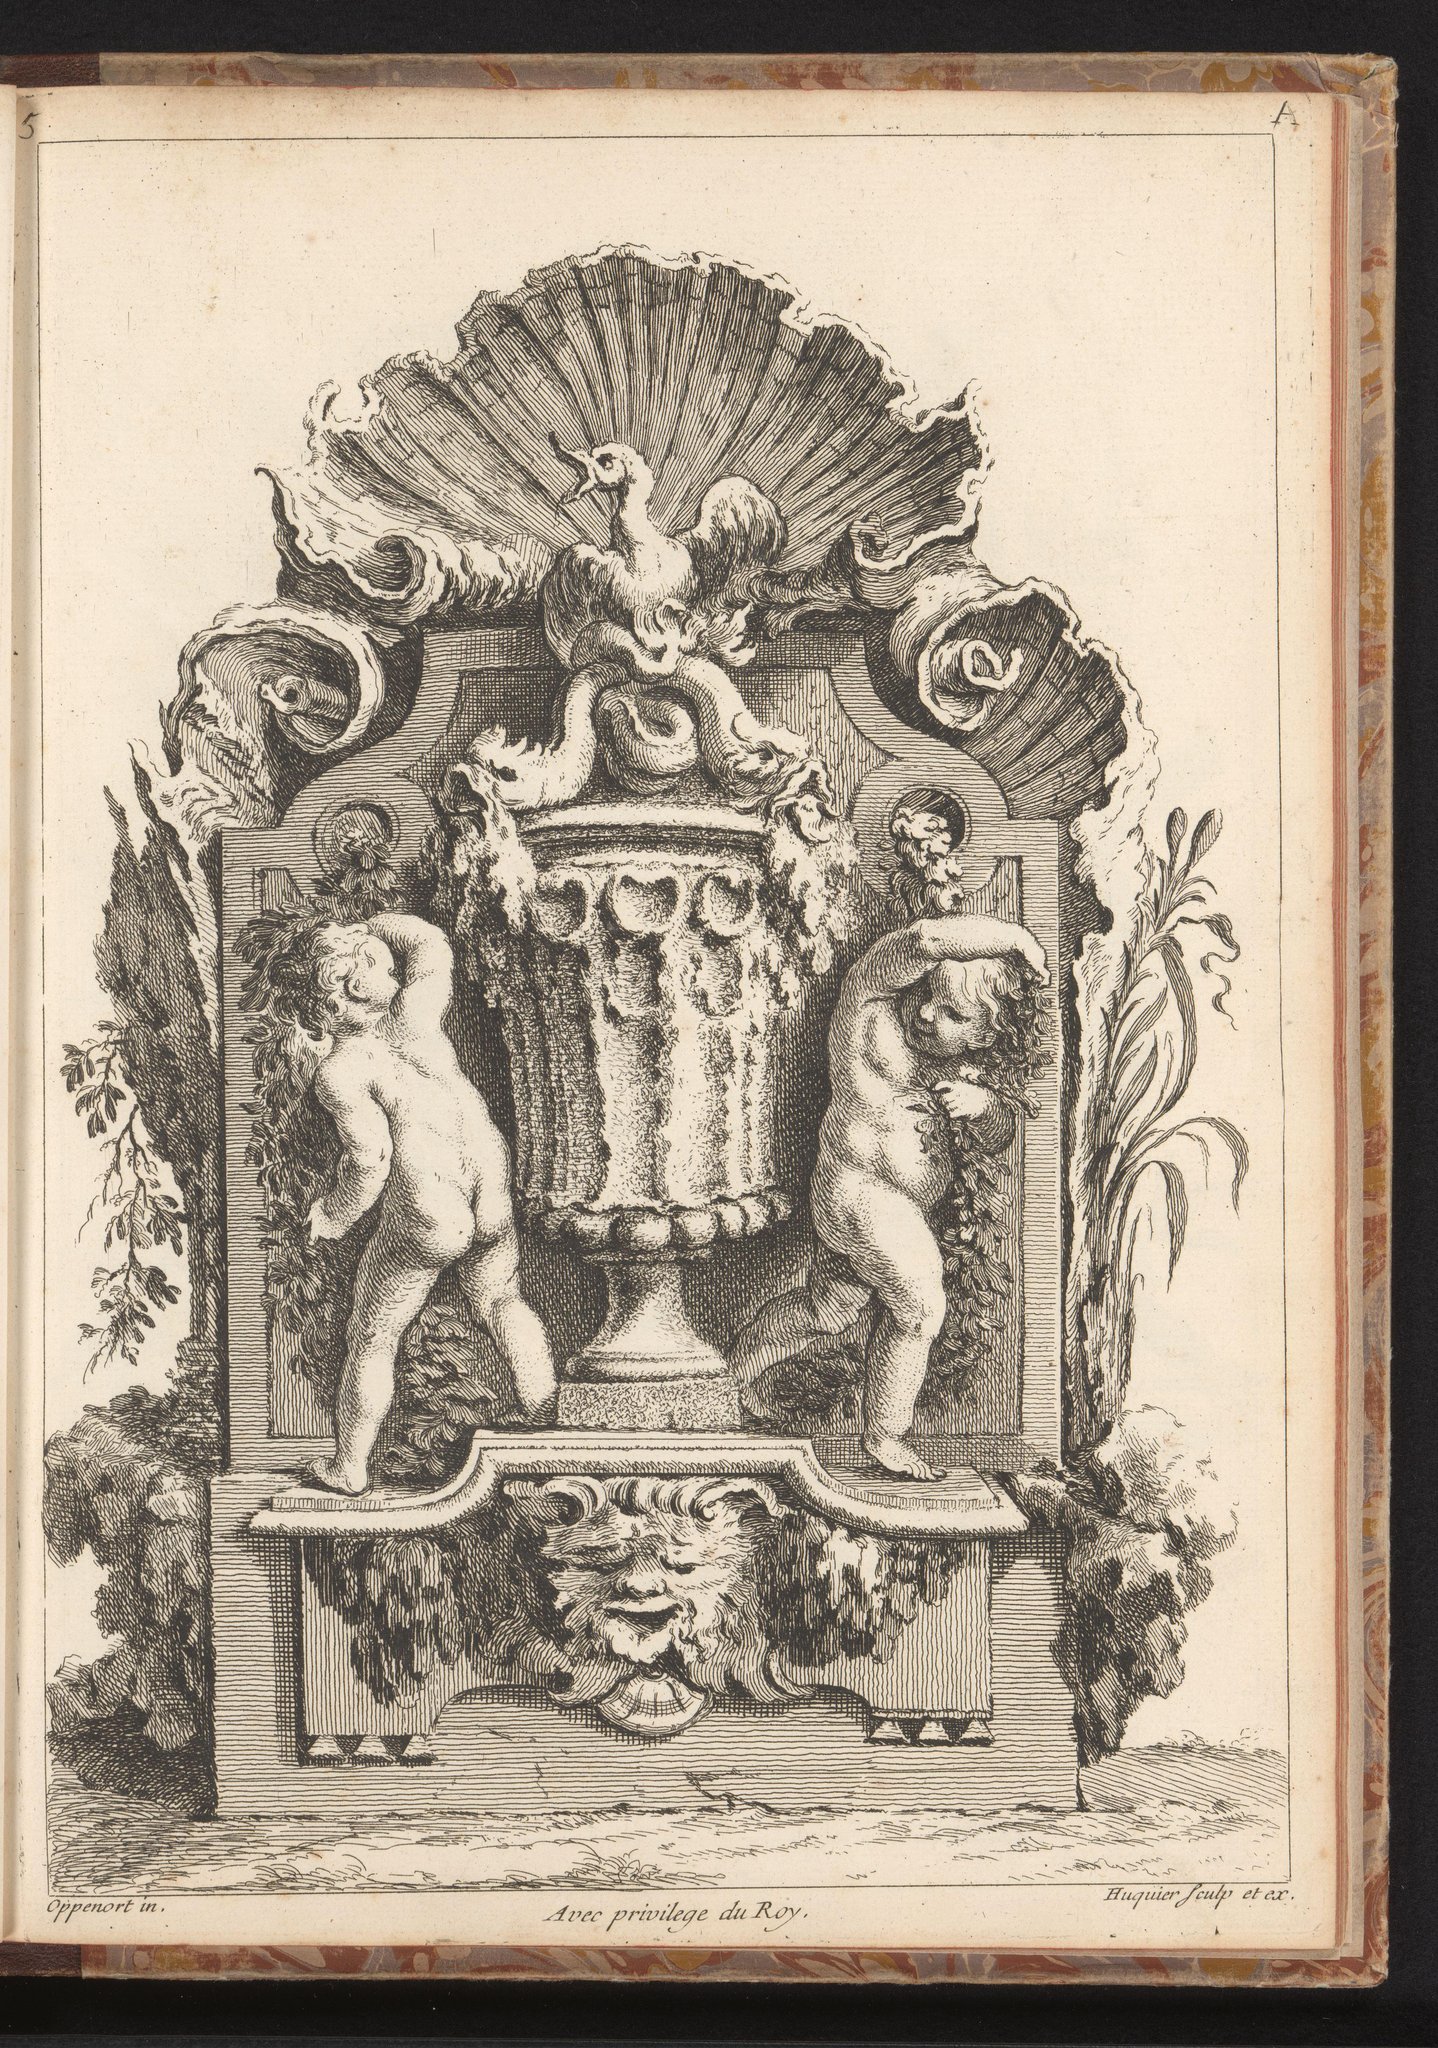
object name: album leaf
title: Ornament met putti aan weerszijden van een vaas met daarop dolfijnen en een vogel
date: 1725-1750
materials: paper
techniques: etching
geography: paris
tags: dolphin ~ ornament, vase ~ ornament, cupids: 'amores', 'amoretti', 'putti'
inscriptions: collector's mark: Lugt 2228a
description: Deze prent maakt deel uit van een album.